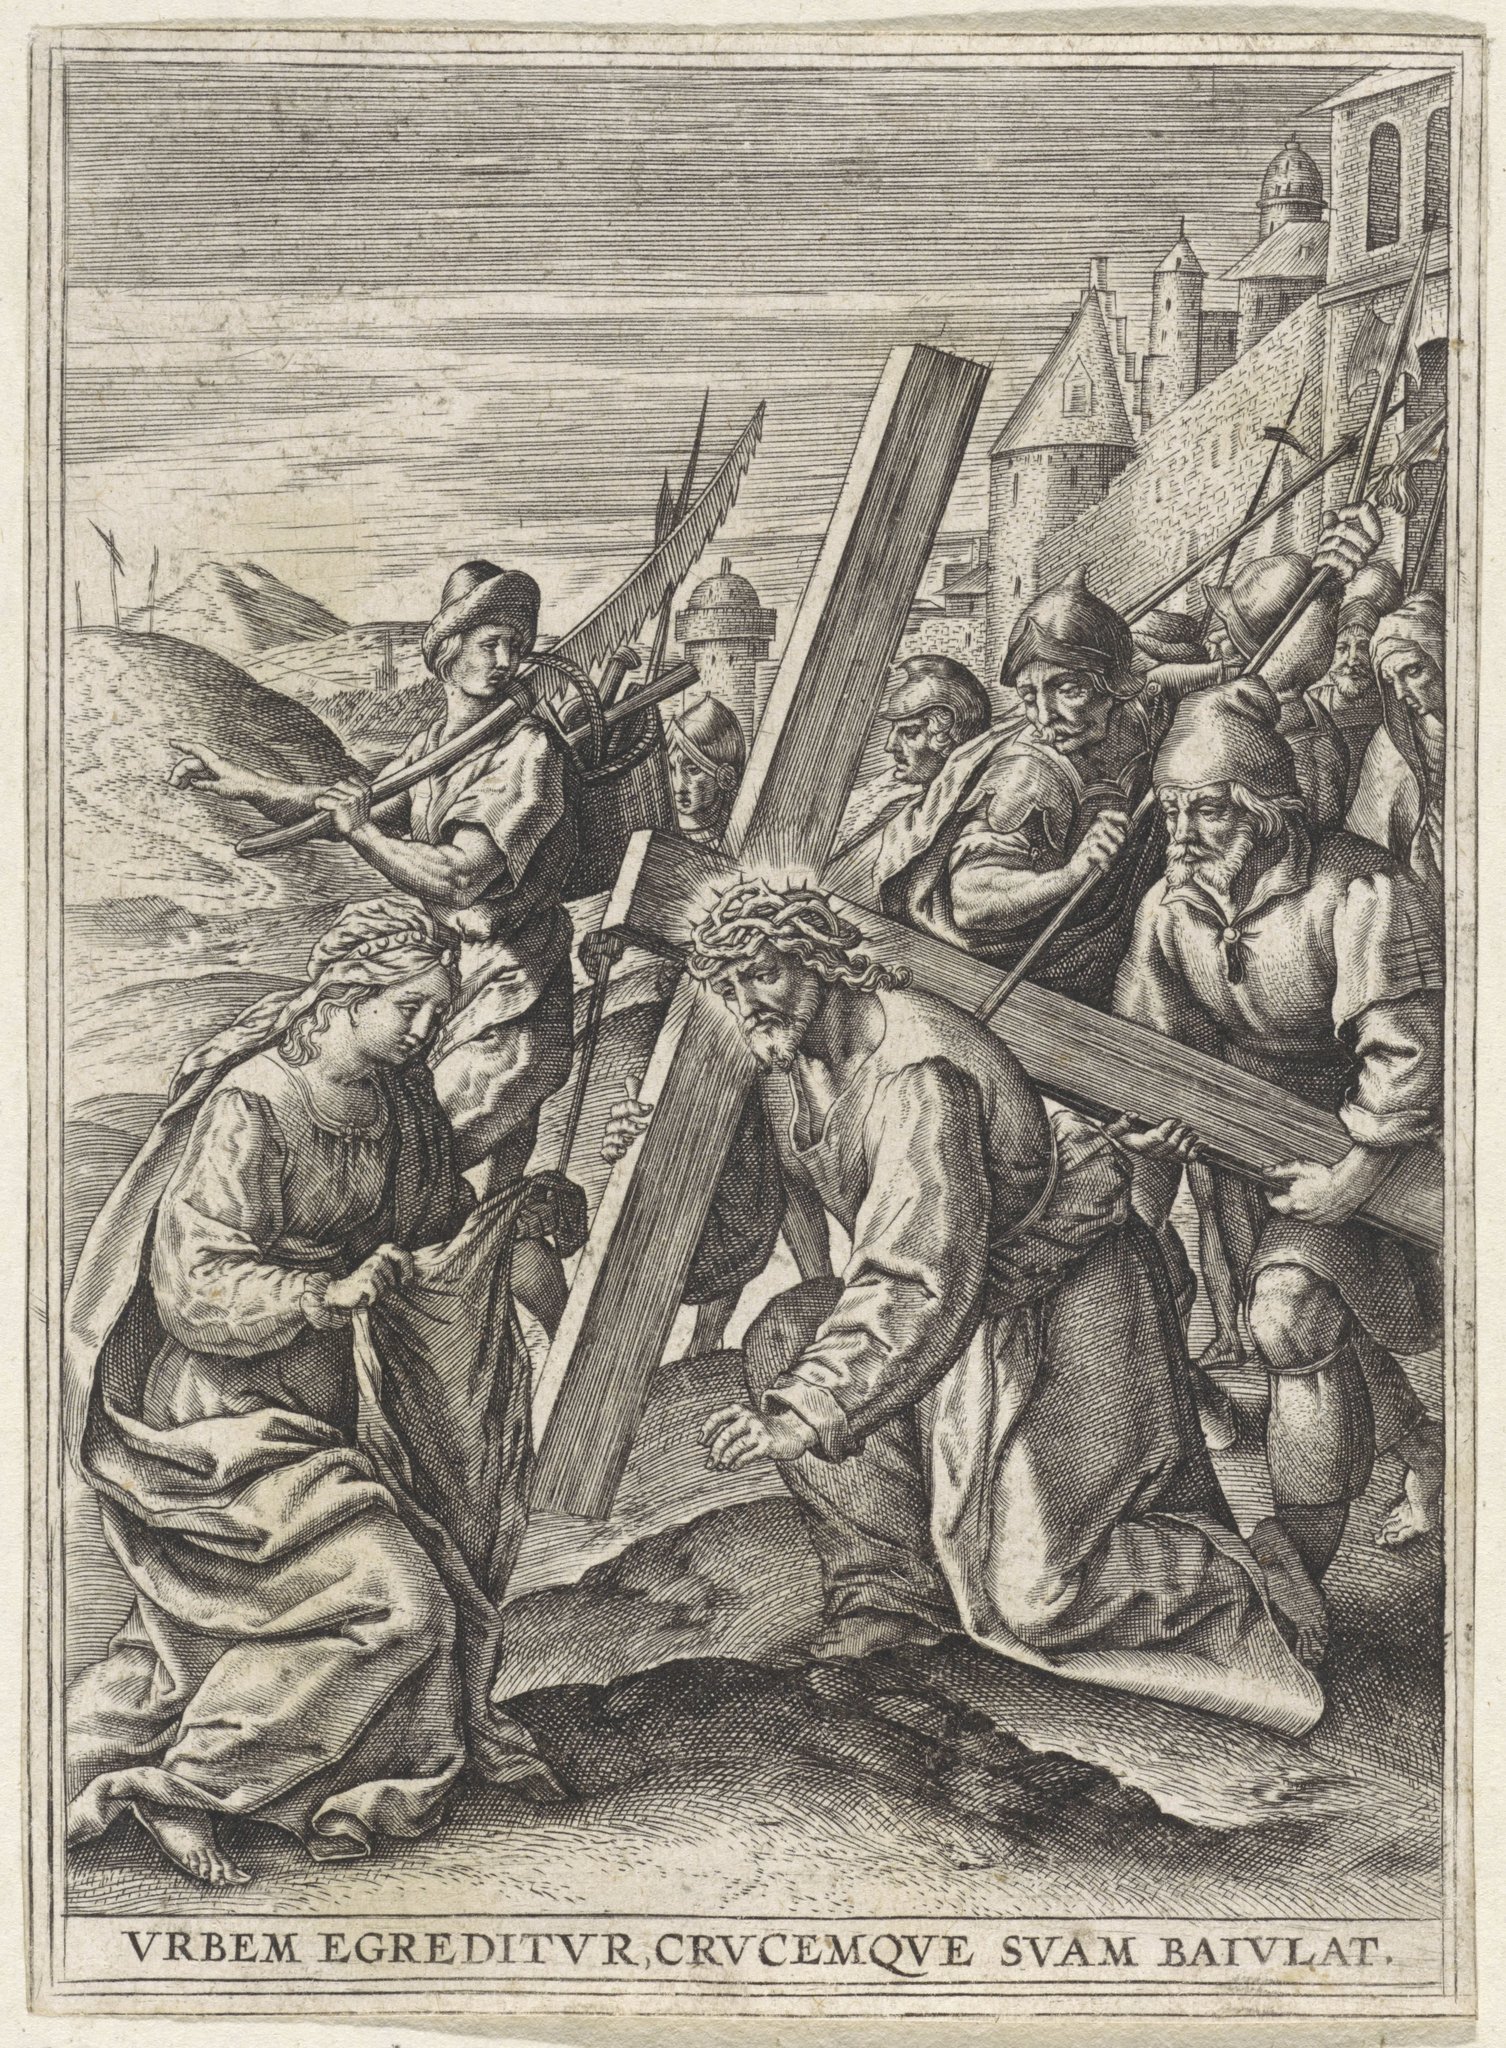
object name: print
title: Kruisdraging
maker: Anonymous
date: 1560-1600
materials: paper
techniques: engraving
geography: antwerp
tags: christ meets veronica, who has a cloth to wipe christ's face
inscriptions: collector's mark: Lugt 240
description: Christus draagt het kruis naar Golgota. Hij wordt geholpen door Simon van Cyrene. Voor Christus knielt Veronica met het sudarium om het zweet van zijn gezicht te wissen. Achter hen gewapende soldaten. Onder een éénregelige toelichting in het Latijn.